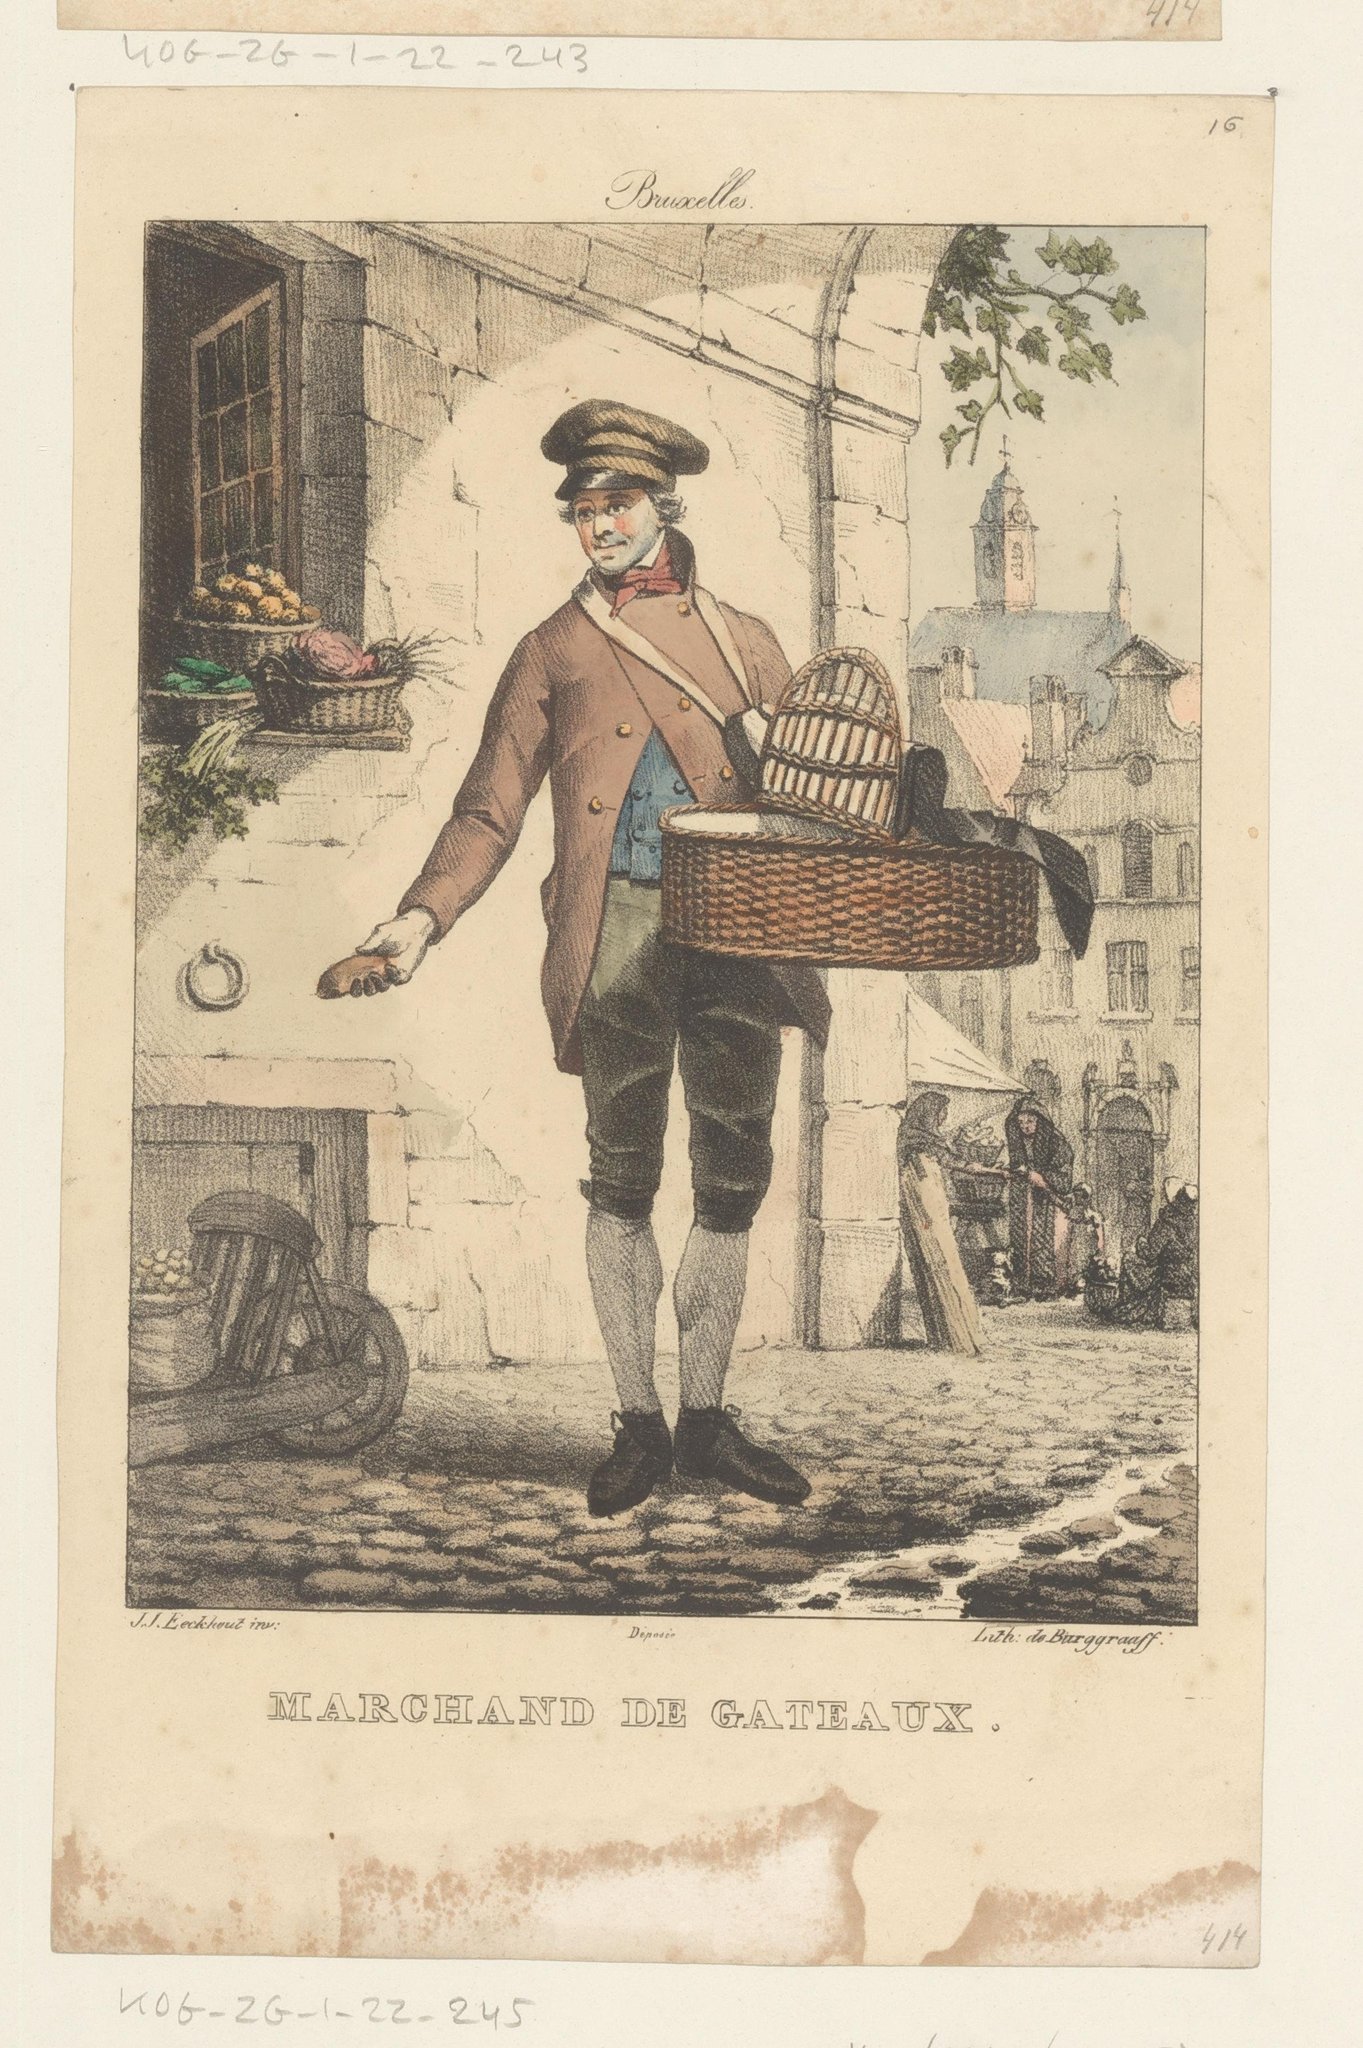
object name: print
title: Kostuums van de inwoners van Nederland en België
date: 1835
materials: paper, watercolor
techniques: hand coloring, lithograph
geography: belgium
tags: cake, tart, pastry, street-trader, clothes, costume (+ men's clothes), folk costume, regional costume, southern netherlands, brussels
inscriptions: collector's mark: Lugt 1641, collector's mark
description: Van den Burggraaff wilde een serie (twintig afleveringen met telkens vier platen) uitgeven met kostuums uit alle provincies van Nederland en België onder de titel 'Costumes du peuple de toutes les provinces des Pays-Bas'. Hij begint met deze serie in 1825 en eindigt hiermee bij de dertiende aflevering in 1830. Omdat in 1830 België zich afsplitst van Nederland geeft hij de prenten daarna apart uit onder de titels 'Costumes de peuple Hollandais' en 'Collection de costumes du peuple des provinces de la Belgique' (1835).